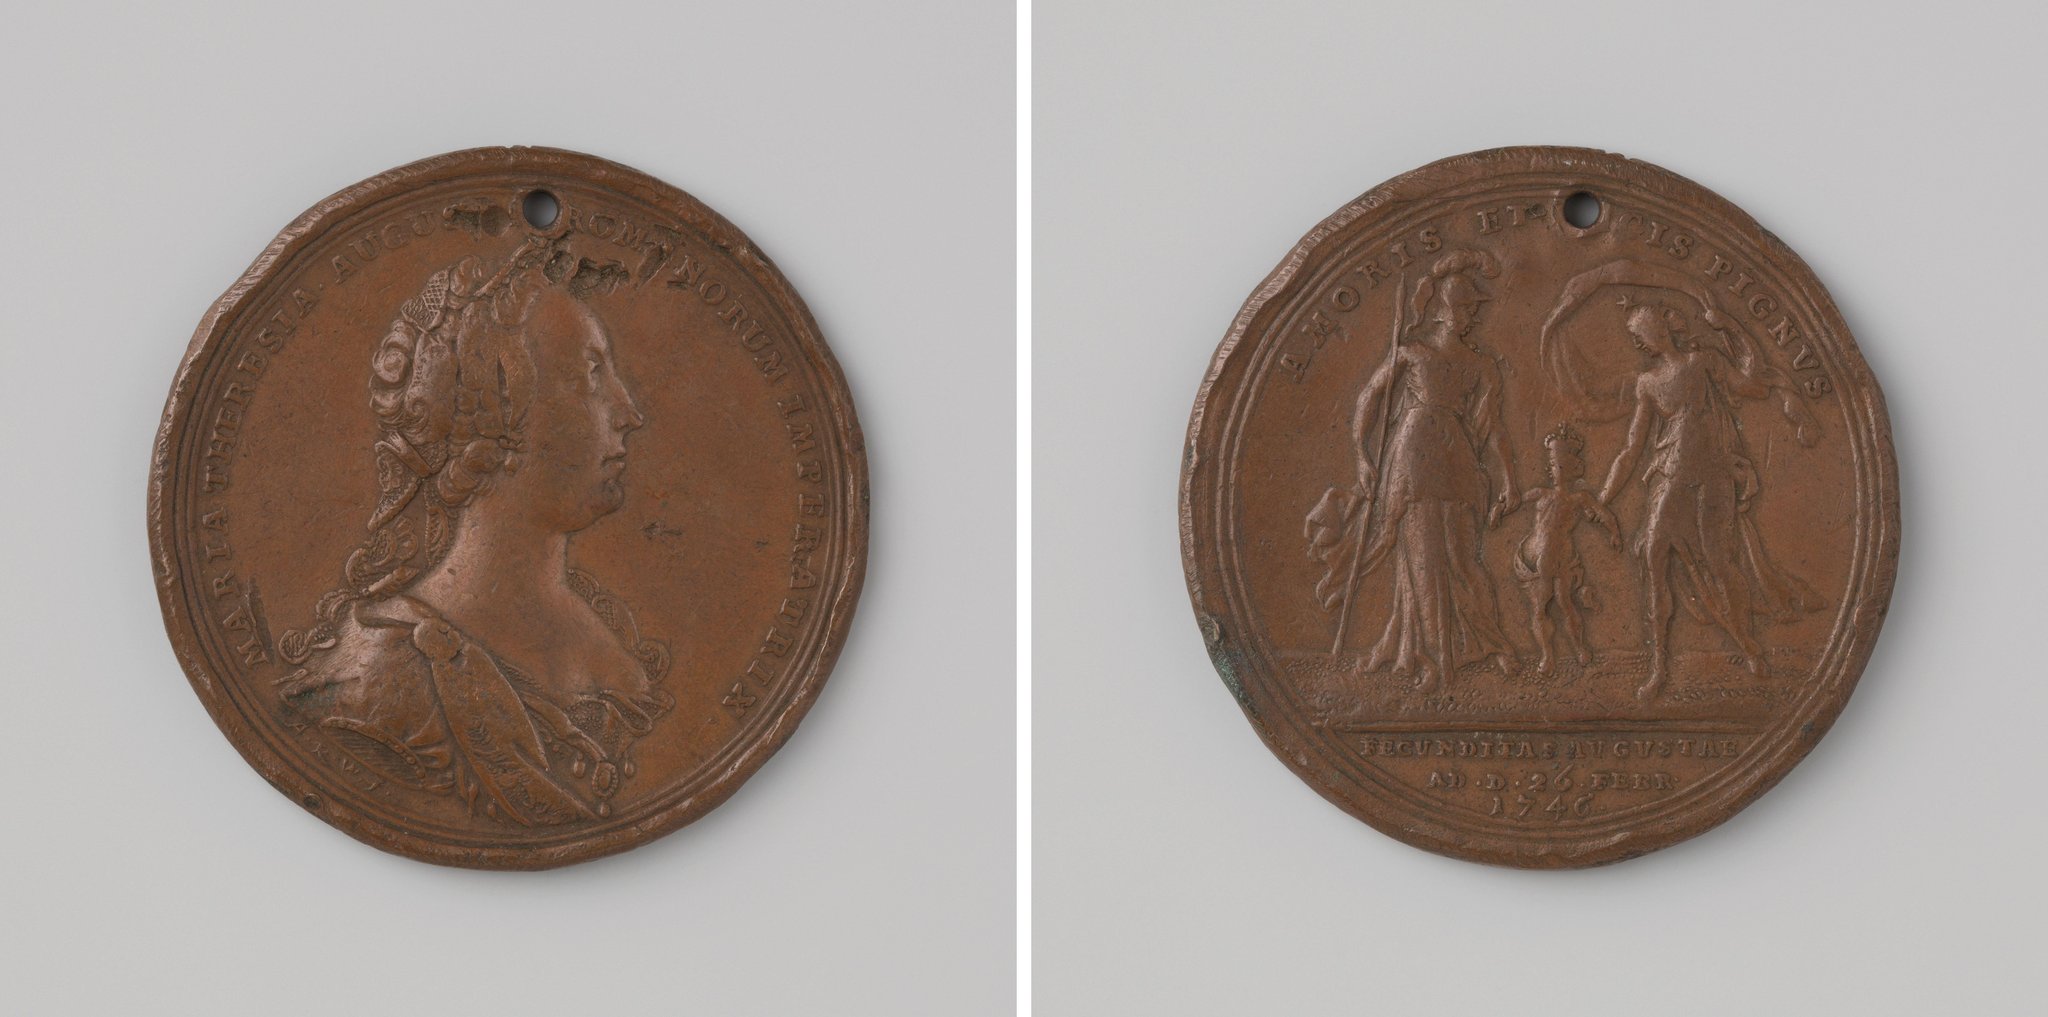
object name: history medal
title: Geboorte van Amalia, aartshertogin van Oostenrijk, dochter van Frans I en Maria Theresia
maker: adam rudolph werner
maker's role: medailleur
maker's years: 1722-1784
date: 1746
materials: bronze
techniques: striking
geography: stuttgart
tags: vienna, maria theresia (rooms-duits keizerin), maria amalia (aartshertogin van oostenrijk)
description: Bronzen penning met gat erin. Voorzijde: borststuk vrouw met diadeem binnnen omschrift. Keerzijde: Minerva met helm en speer en Venus met sluier en ster op haar hoofd leiden gezamelijk pas geboren prinses, die kroon draagt binnen omschrift; afsnede: opschrift